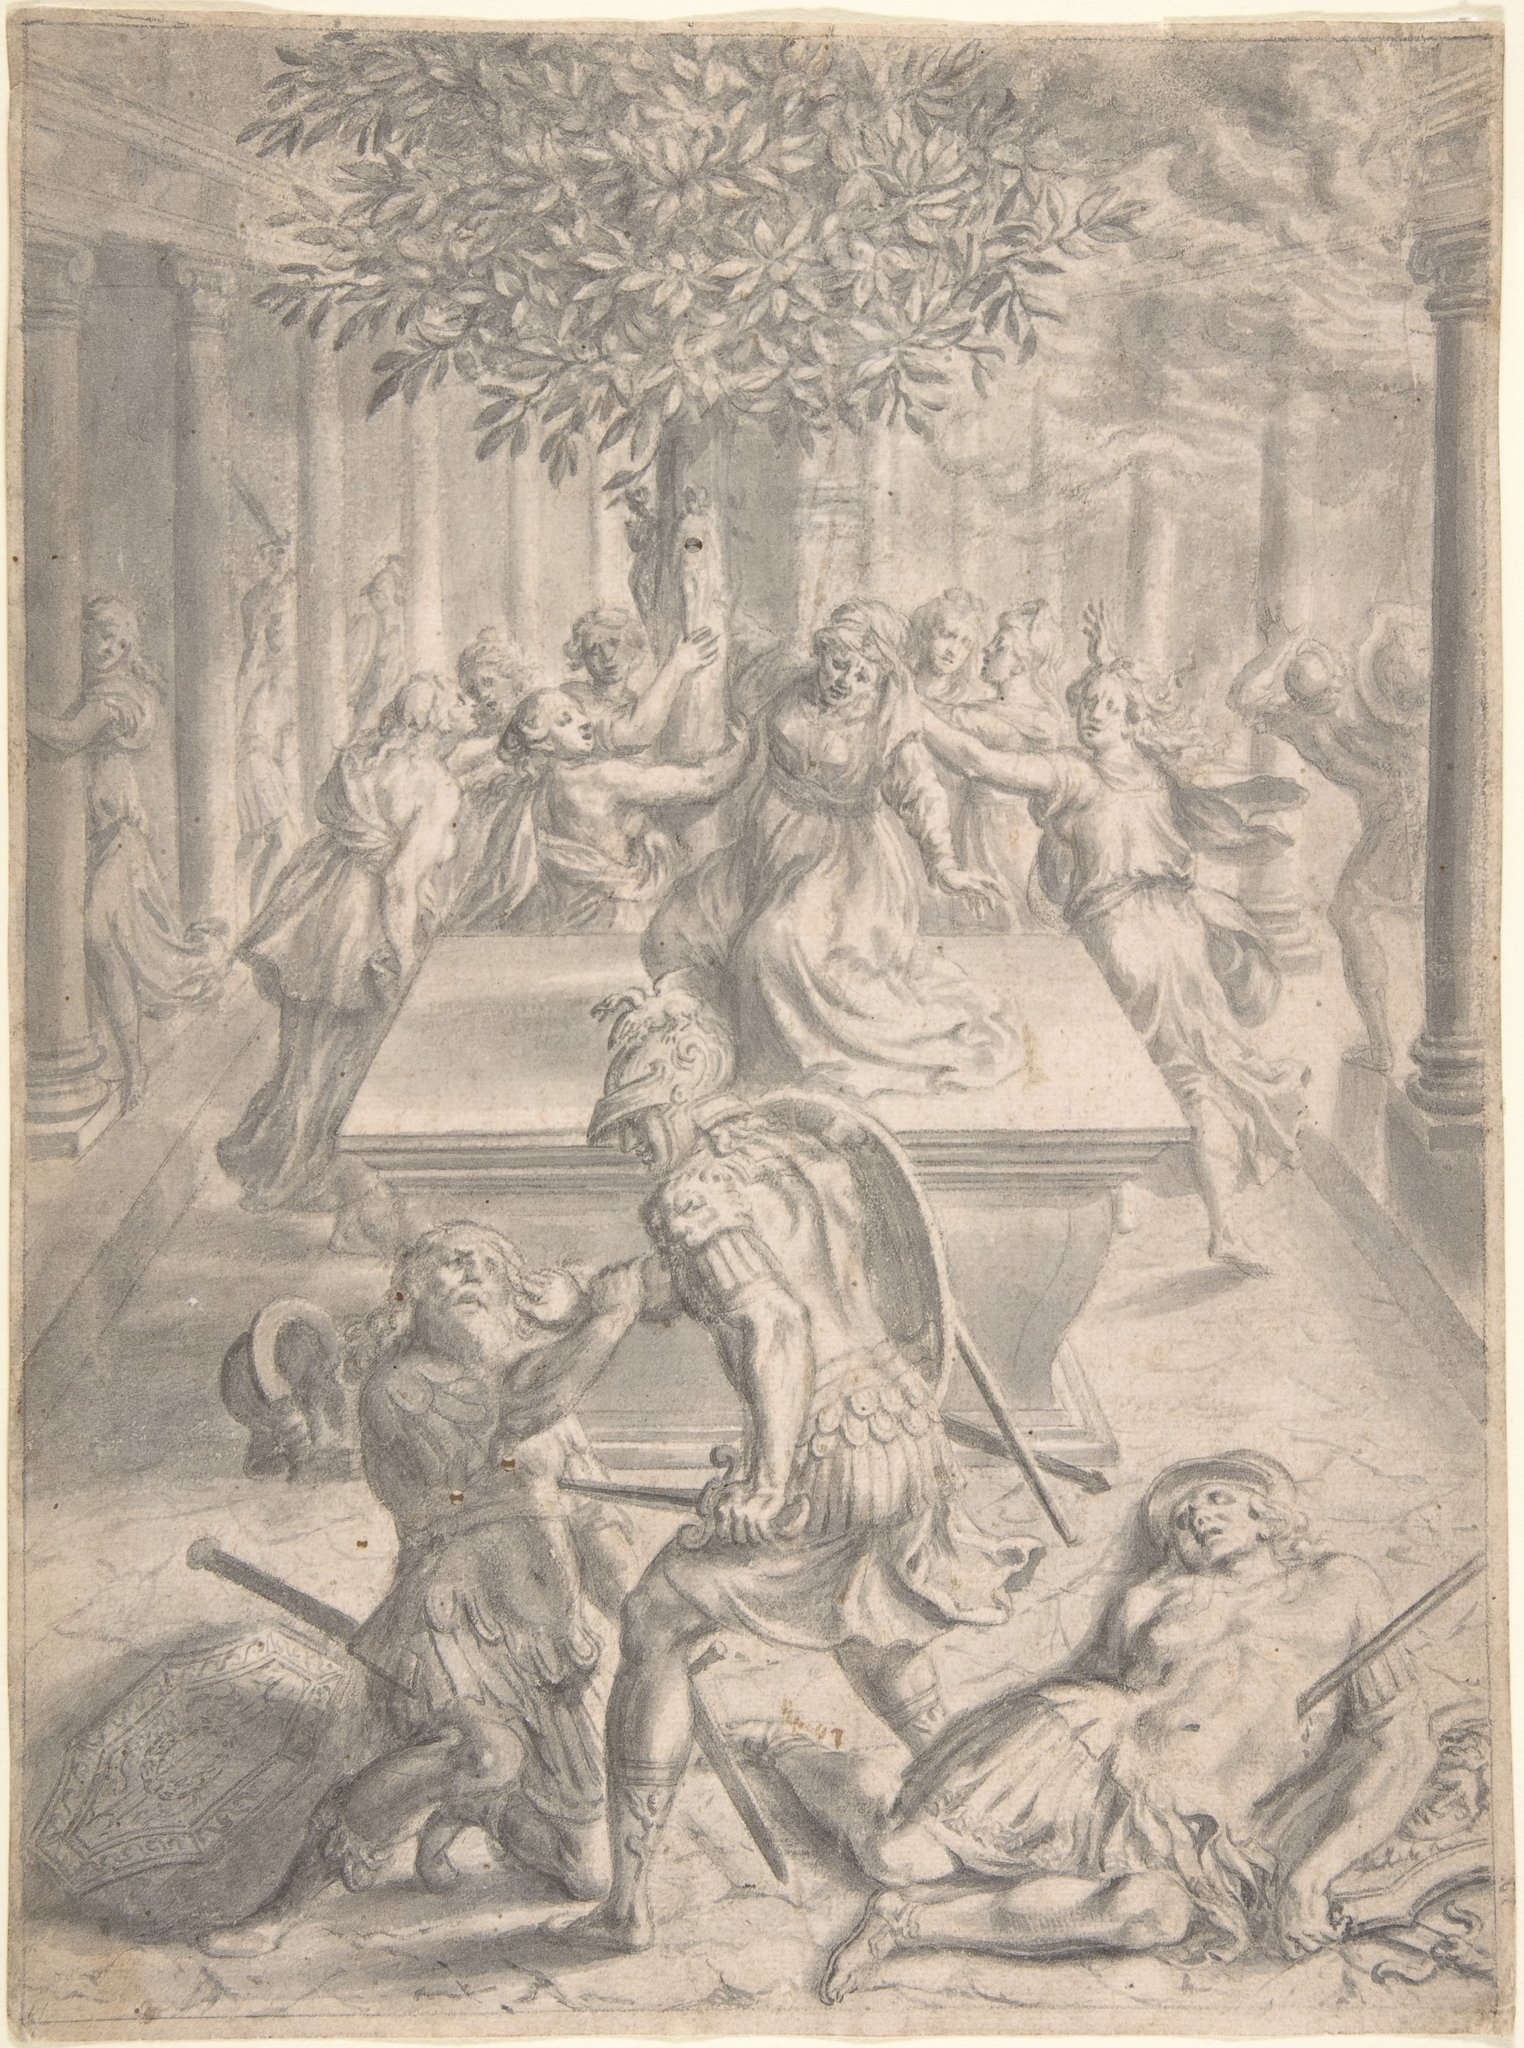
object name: drawing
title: The Sack of Troy: Pyrrhus Killing Priam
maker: franz cleyn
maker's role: artist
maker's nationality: german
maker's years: 1582-1658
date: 1654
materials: chalk, graphite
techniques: incising, transfer, wash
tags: soldiers,kings,women,death